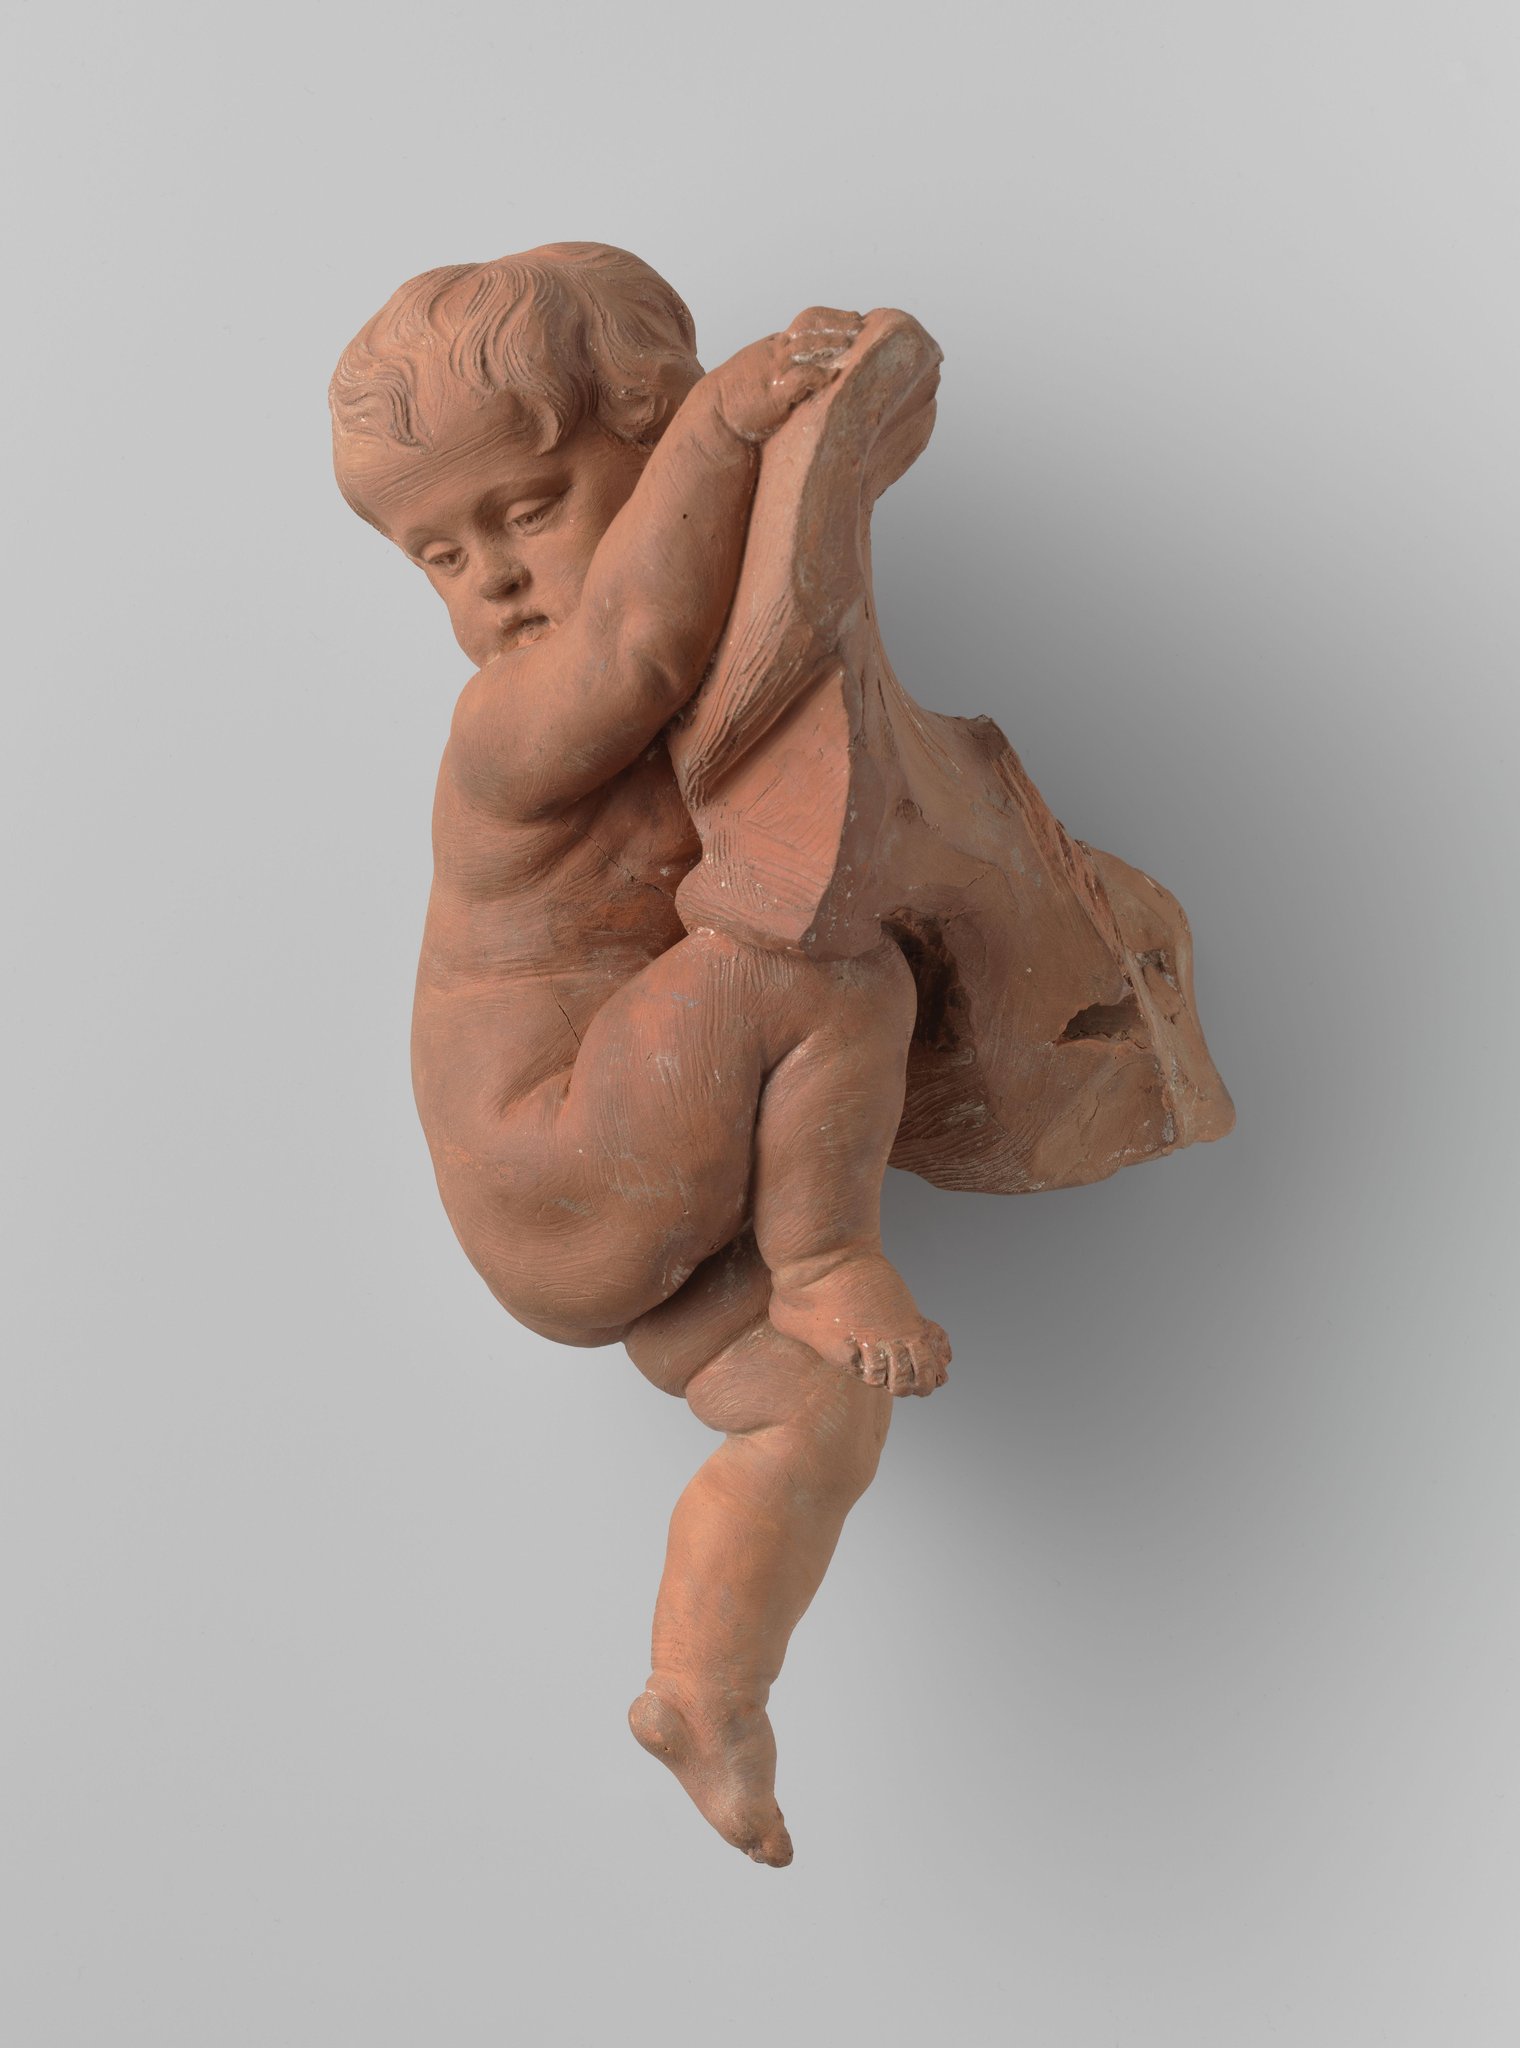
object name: sculpture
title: Study for a Hovering Putto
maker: laurent delvaux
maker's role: sculptor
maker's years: 1696-1778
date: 1735-1750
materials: terracotta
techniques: modeling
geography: southern netherlands